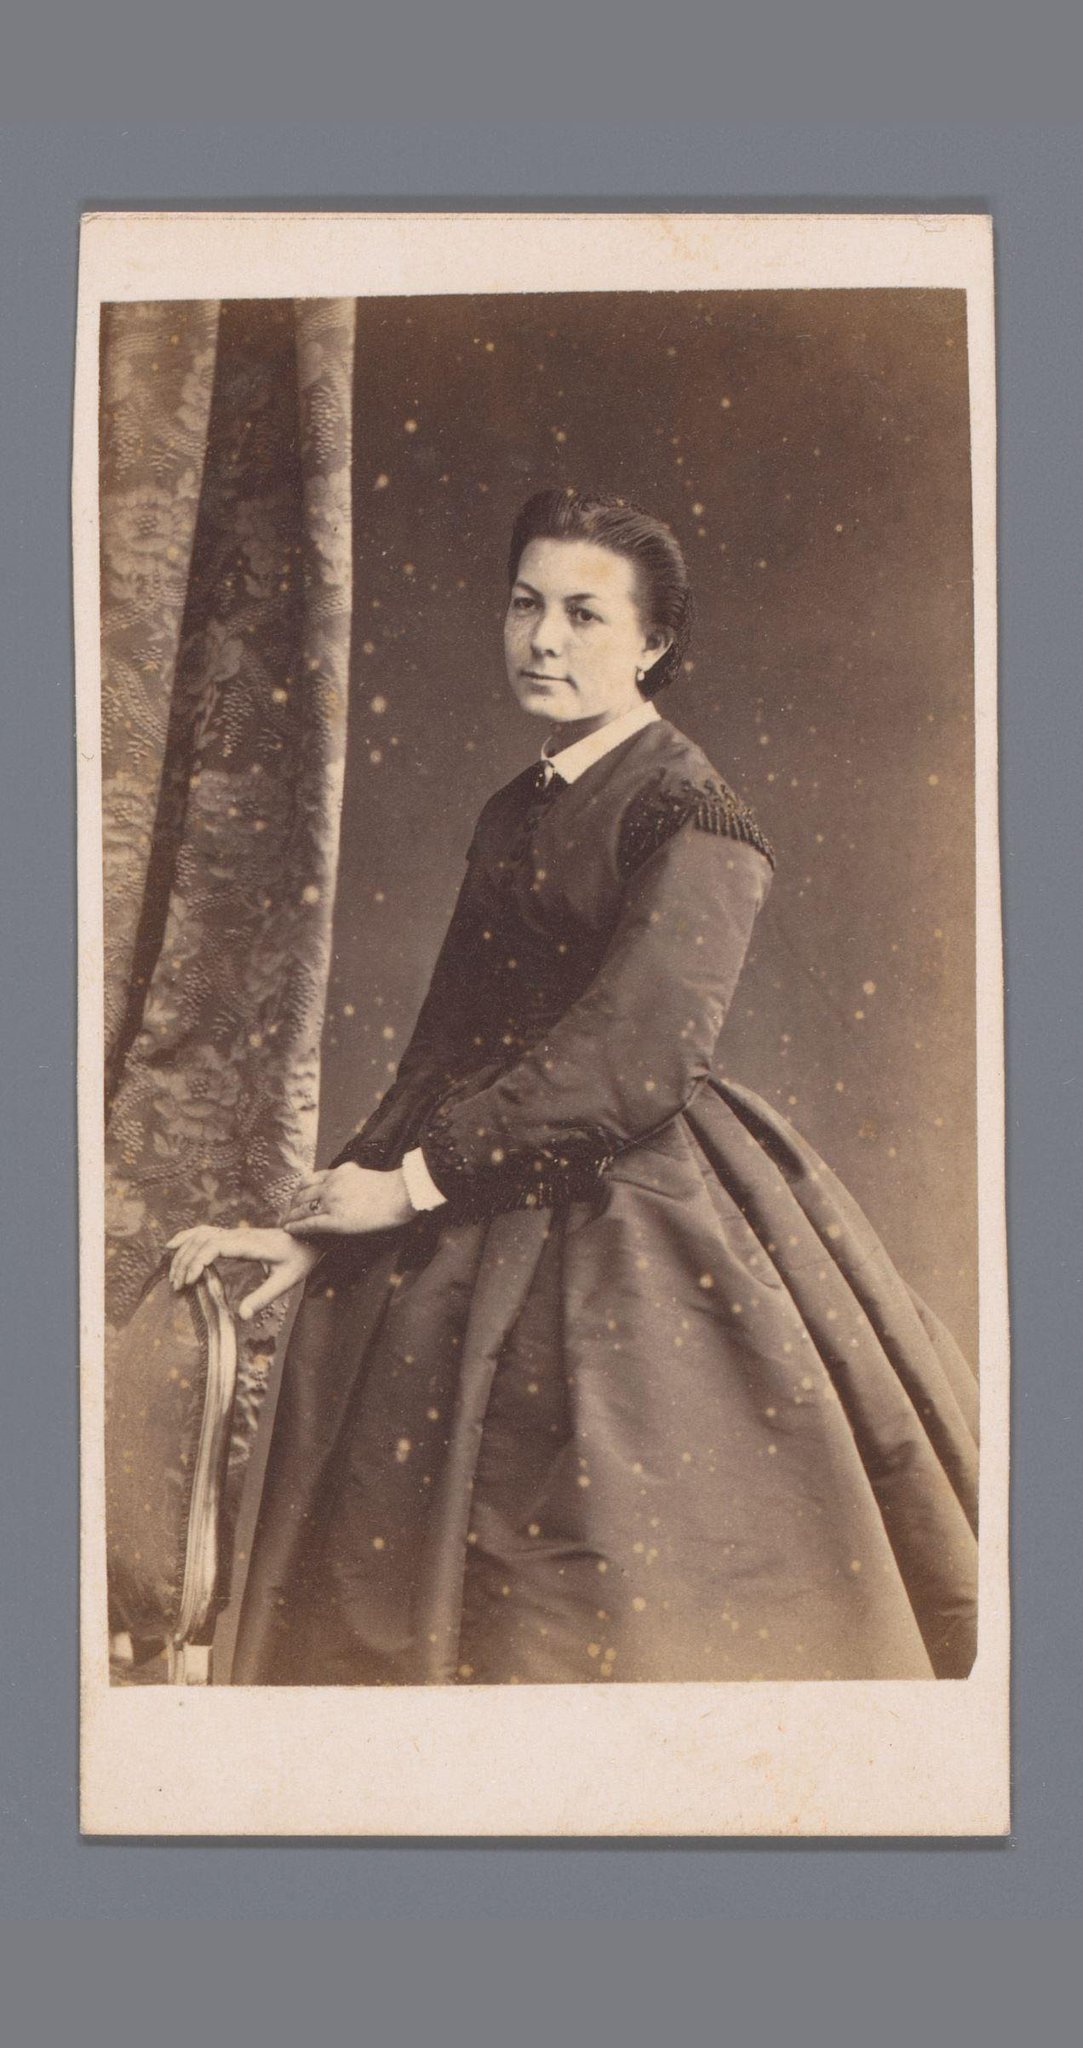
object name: carte de visite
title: Portret van een onbekende vrouw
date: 1855-1870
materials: cardboard, paper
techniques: albumen print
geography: paris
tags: adult woman, anonymous historical person portrayed, paris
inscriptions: inscription: ‘Photographie/ de/ la Presse Artistique/ 123, rue Montmartre, 123/ Paris.’